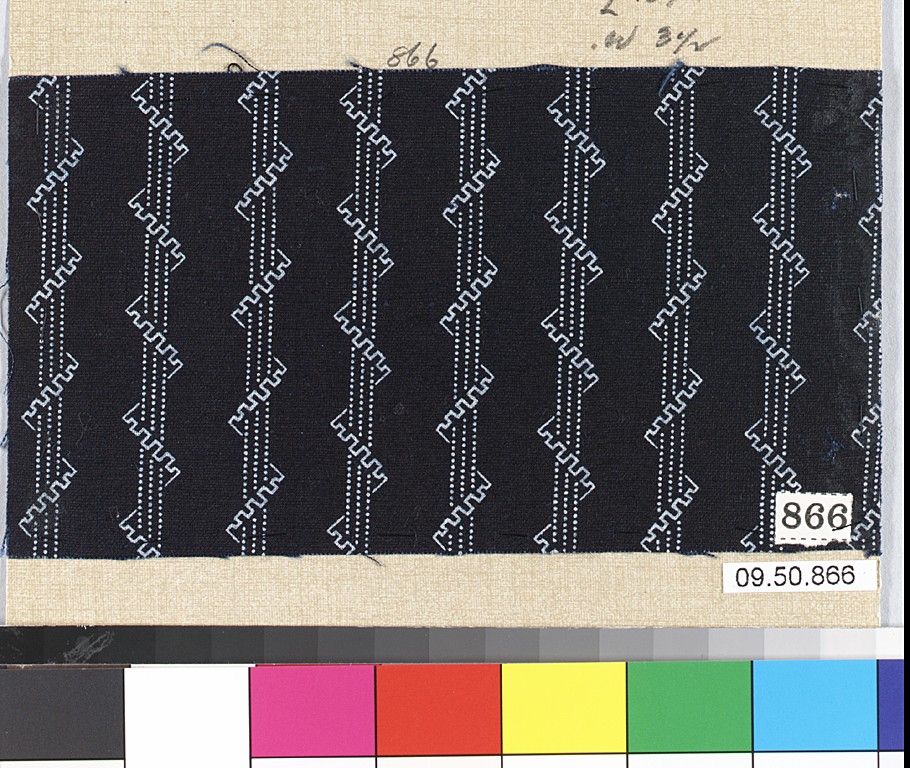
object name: piece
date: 1801-1900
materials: cotton